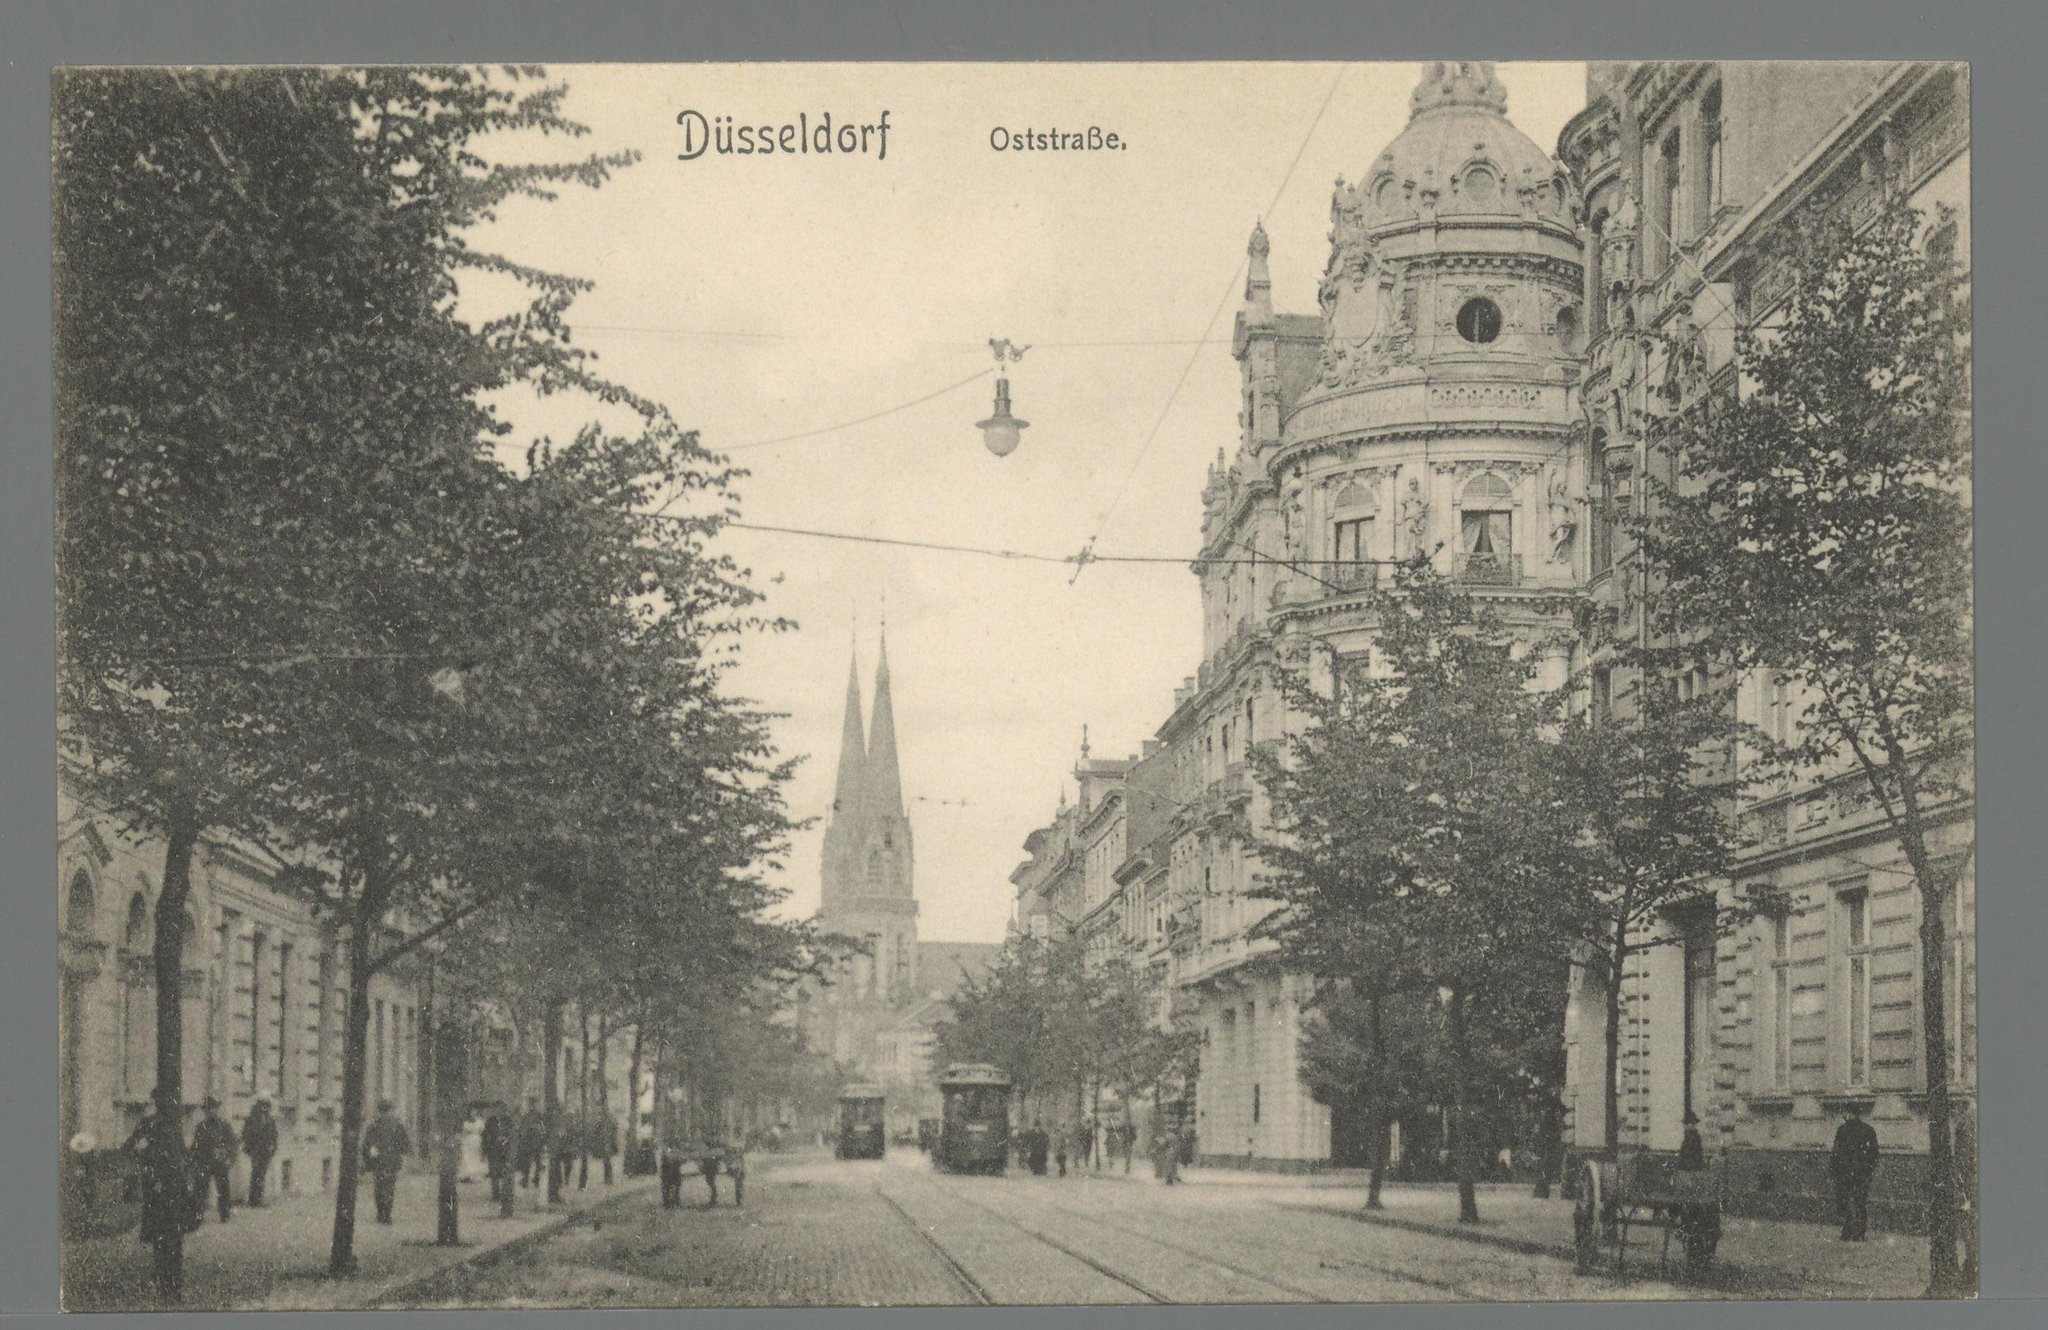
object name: photomechanical print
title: Düsseldorf. Oststraβe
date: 1905-1930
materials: cardboard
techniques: photograph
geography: dusseldorf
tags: church (exterior), street